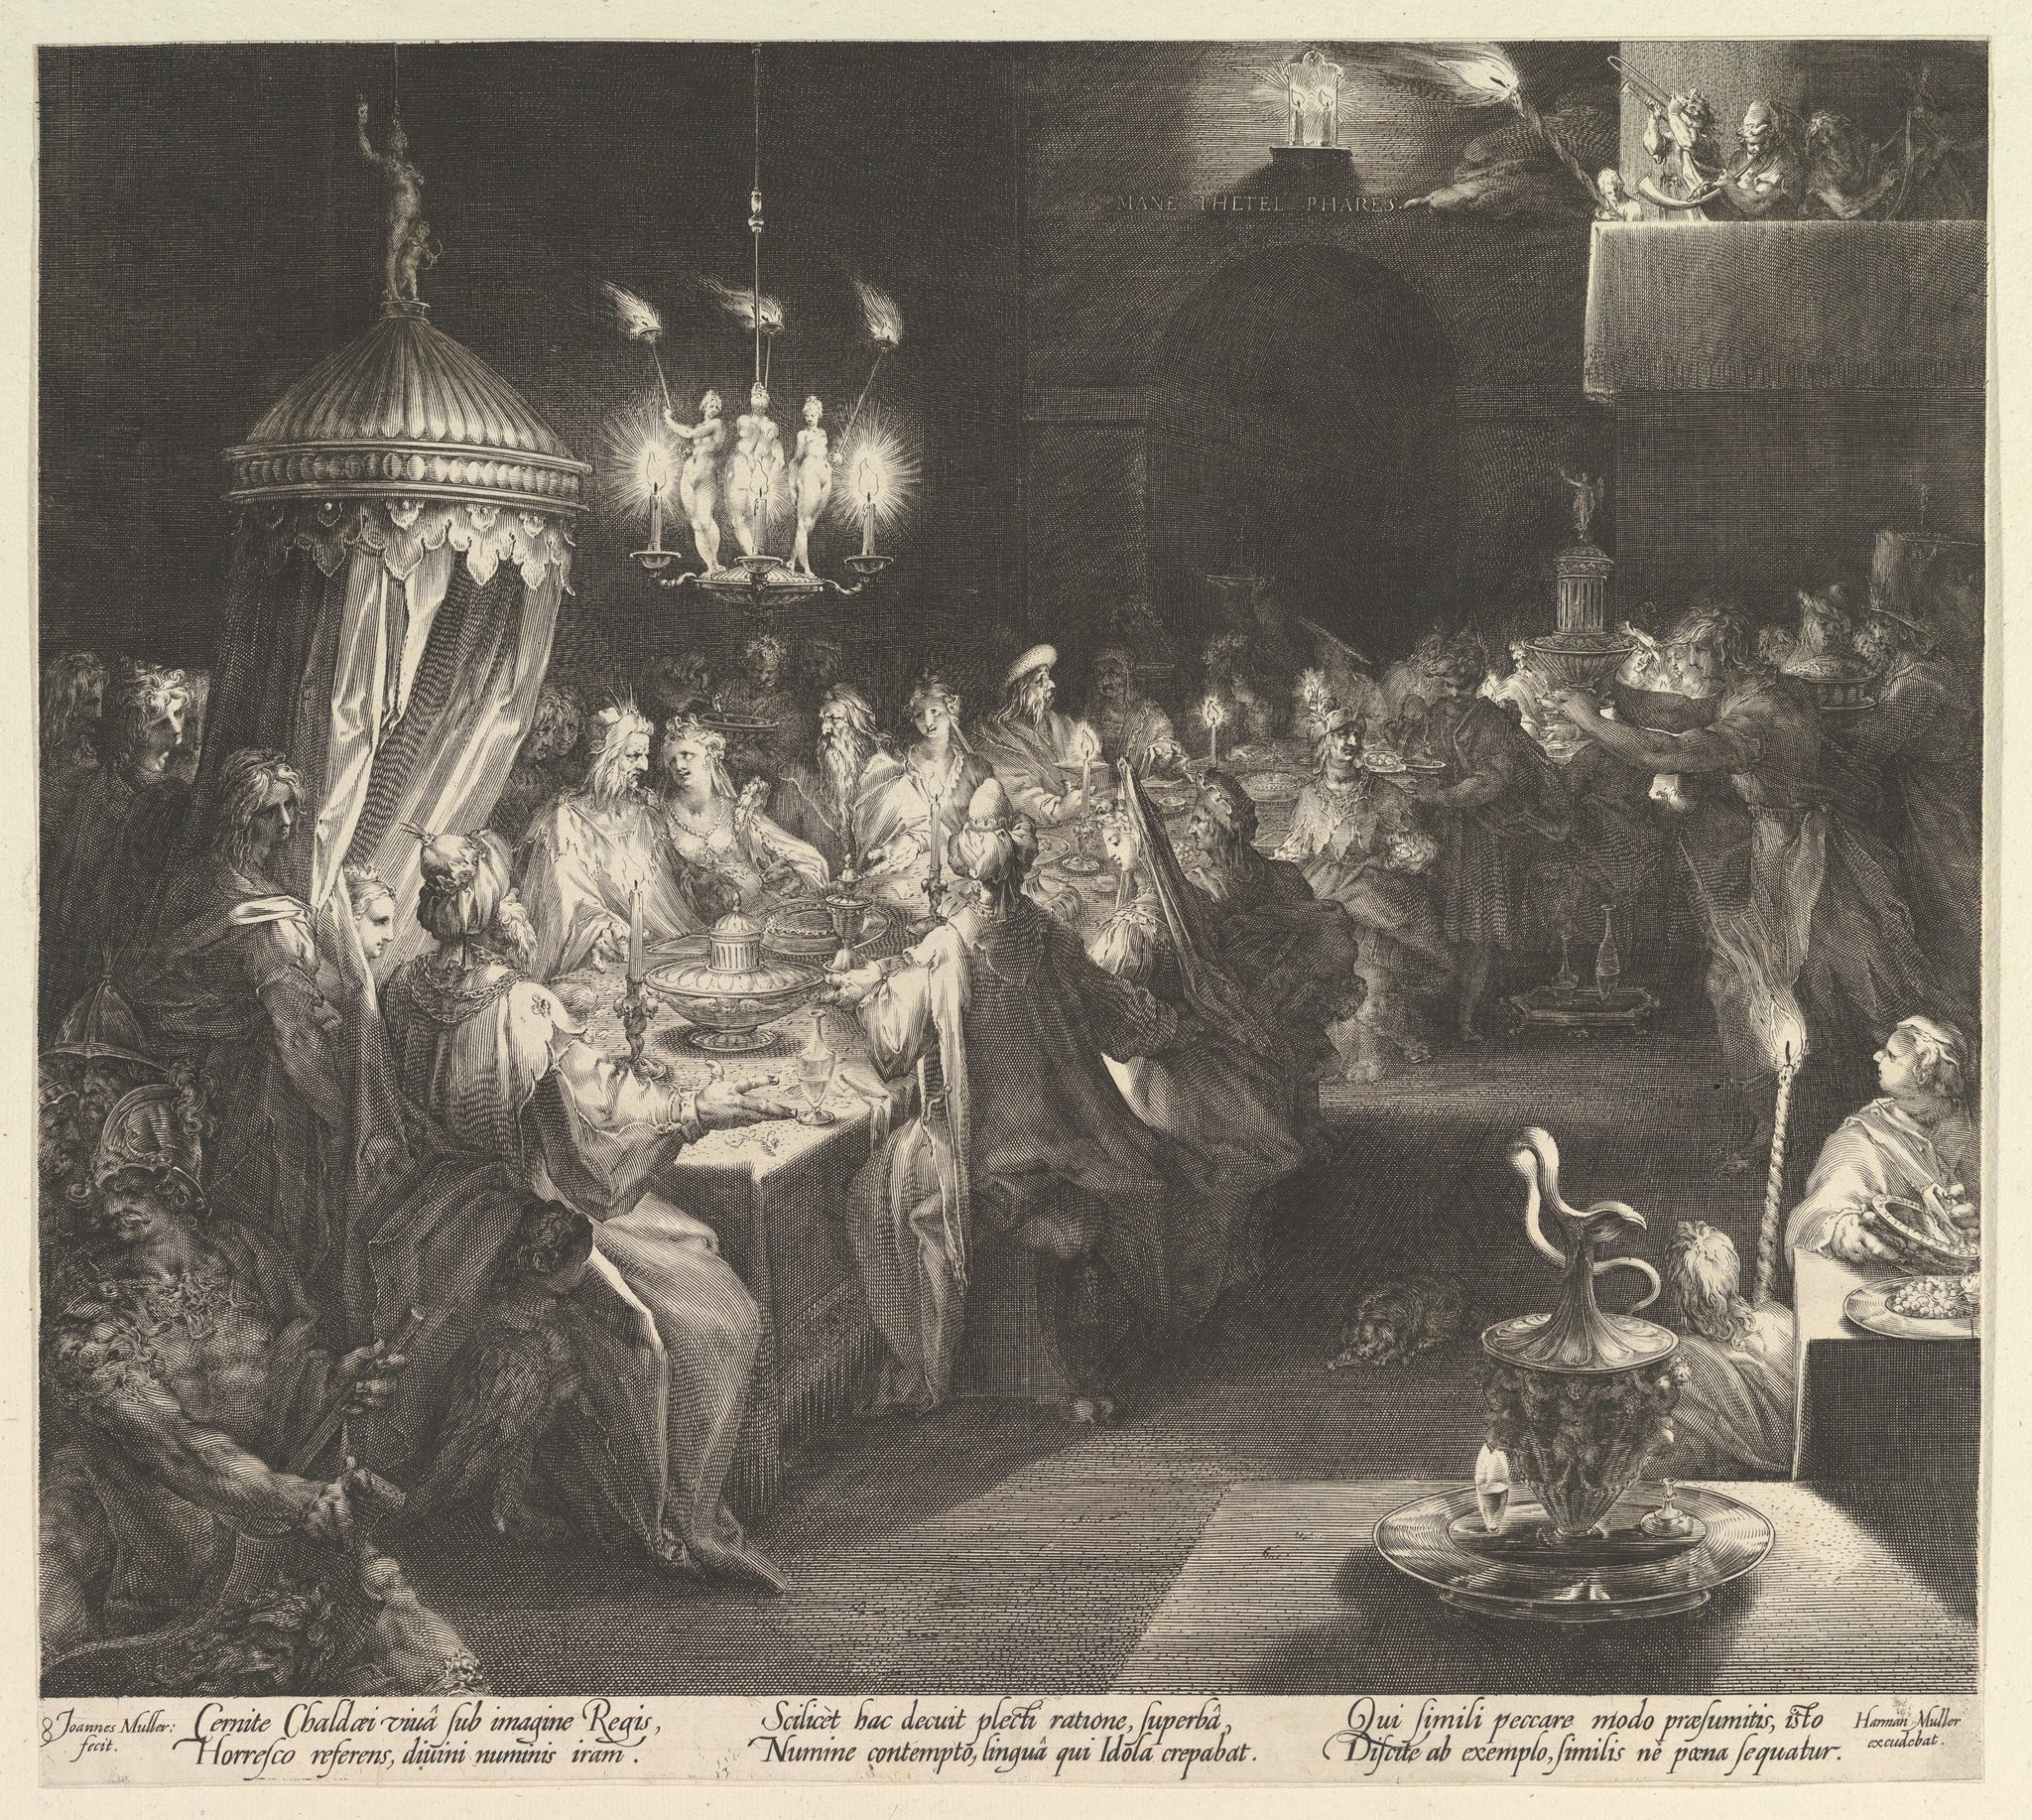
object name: print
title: Belshazzar's Feast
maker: jan muller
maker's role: artist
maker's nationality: netherlandish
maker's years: 1571-1628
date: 1598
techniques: engraving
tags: men,women,dining